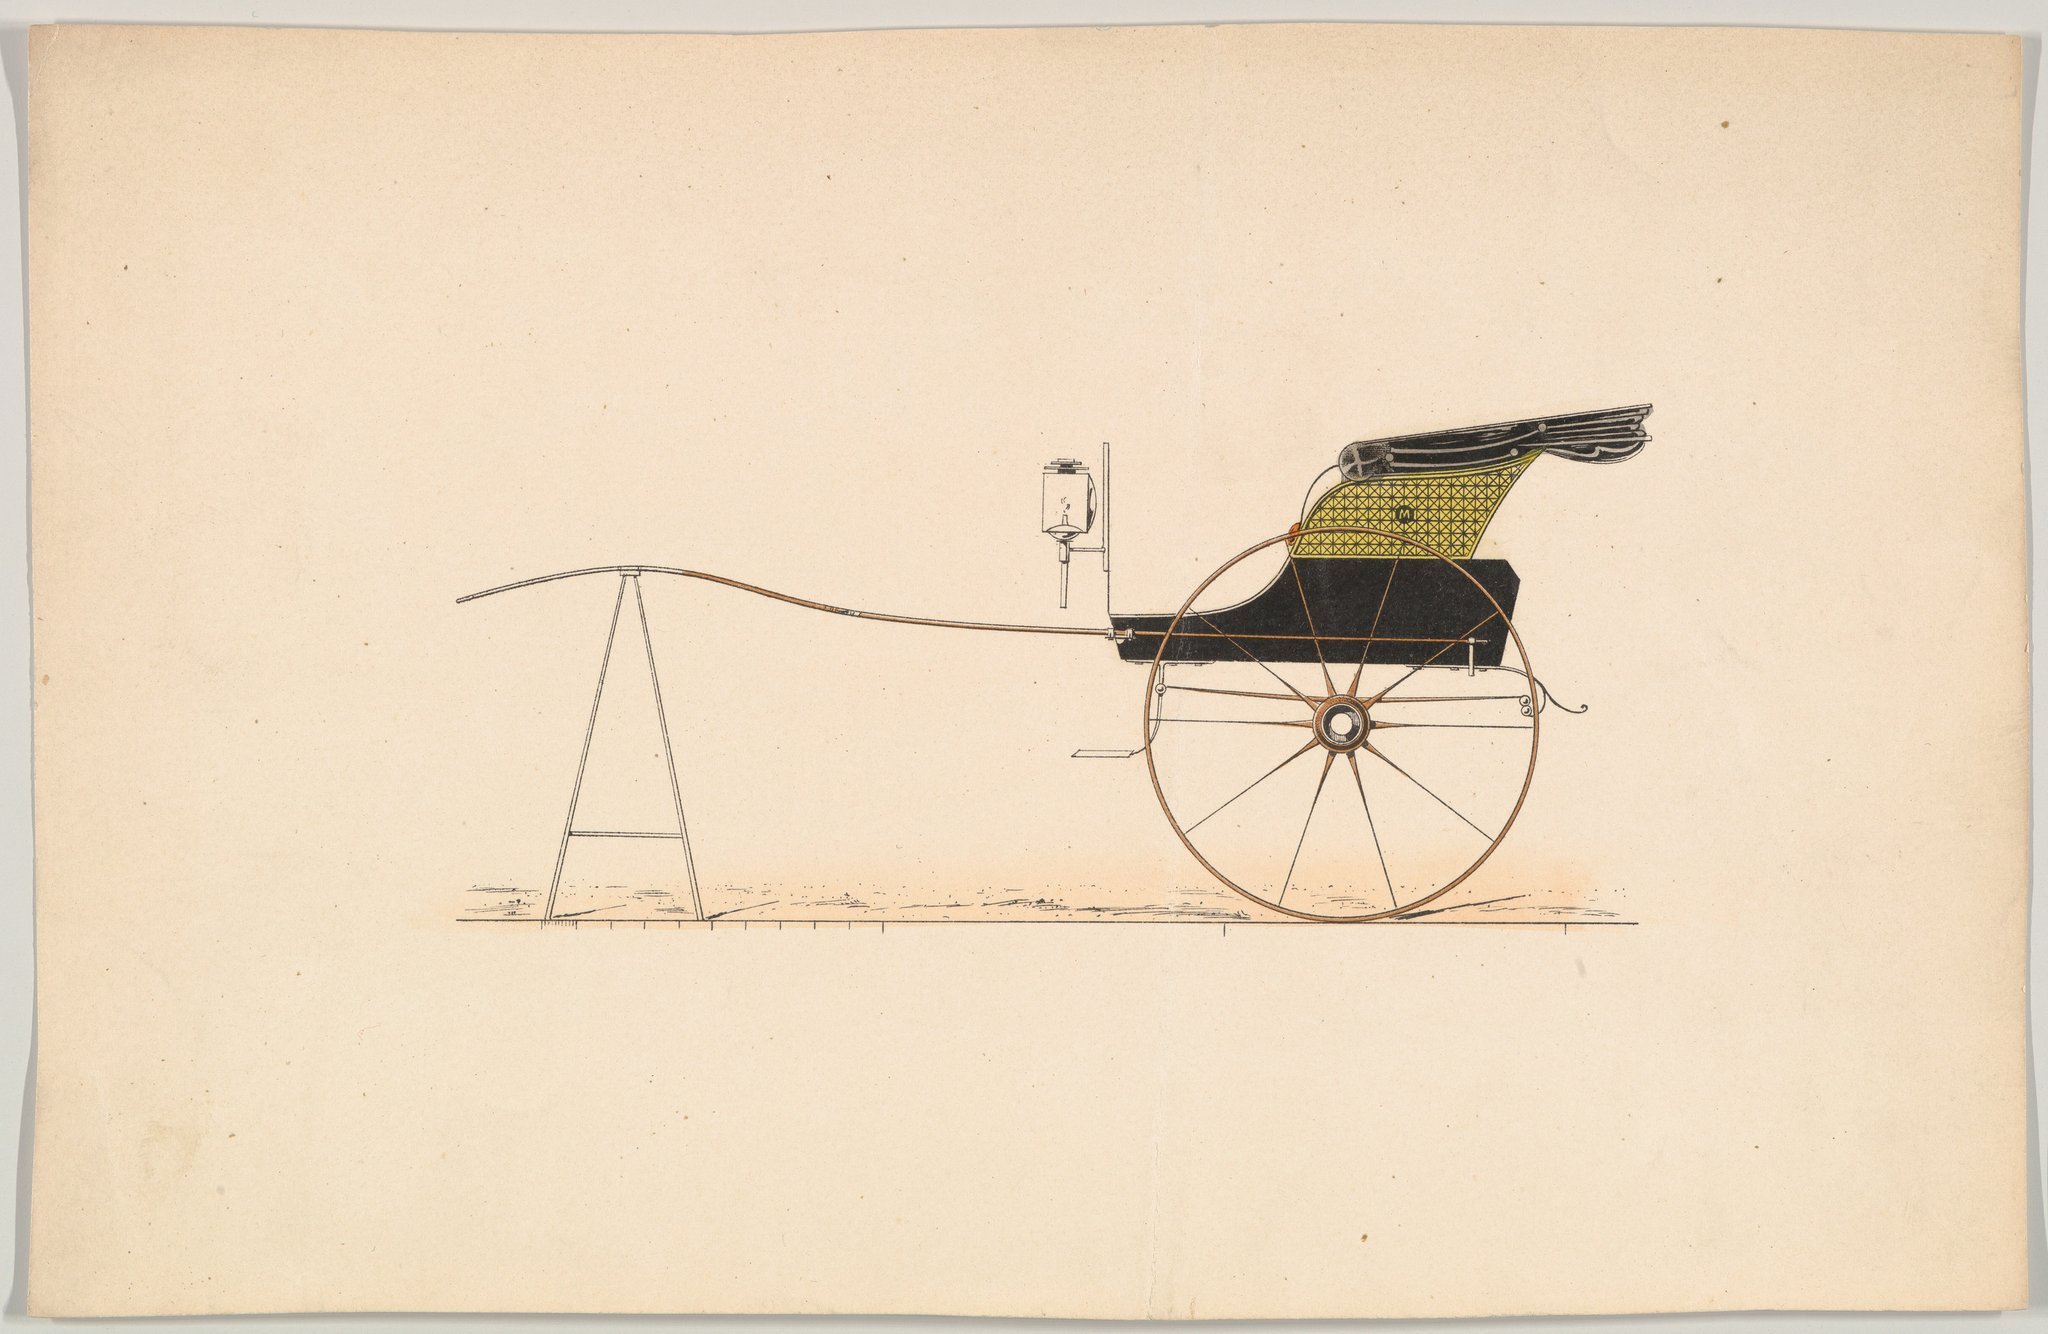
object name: print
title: Chaise (unnumbered)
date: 1850-1874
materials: gum arabic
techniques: engraving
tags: carriages